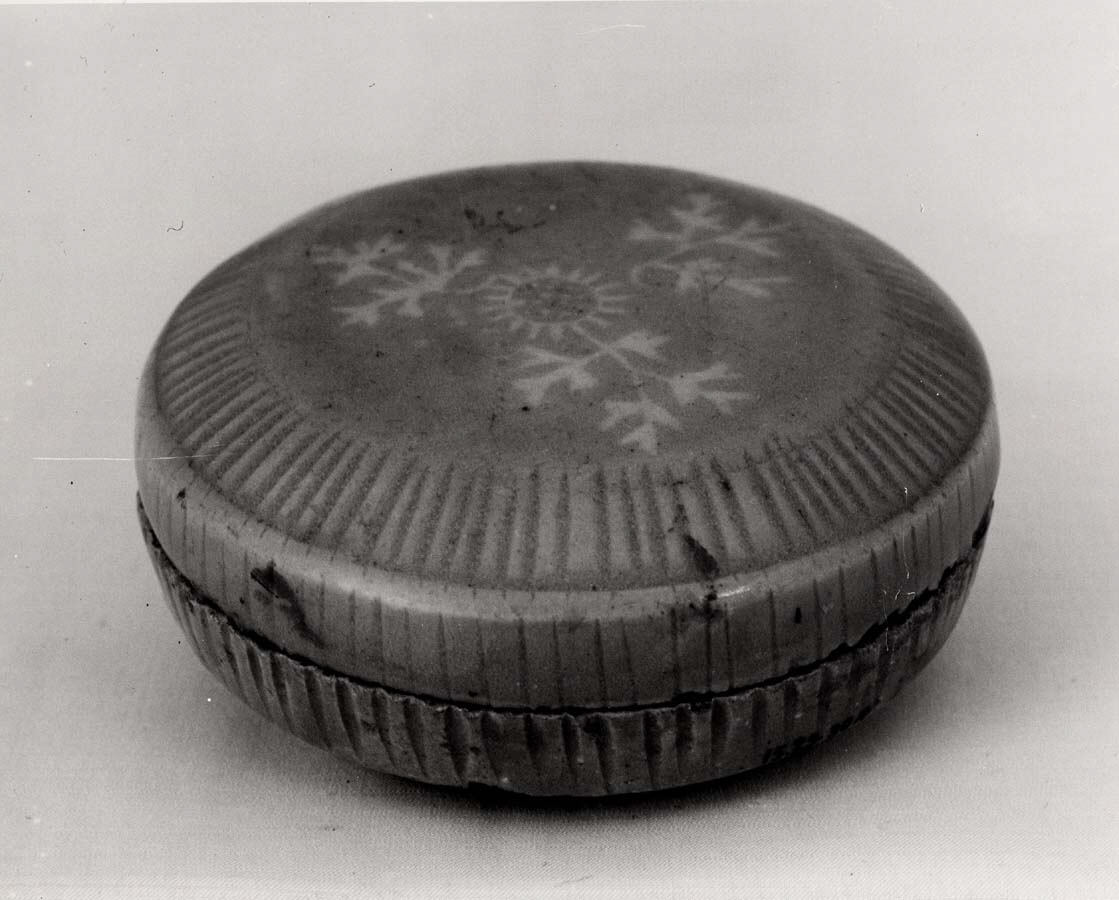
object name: box with cover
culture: korean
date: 1901-2000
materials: ceramic glaze, glaze, stoneware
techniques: inlay